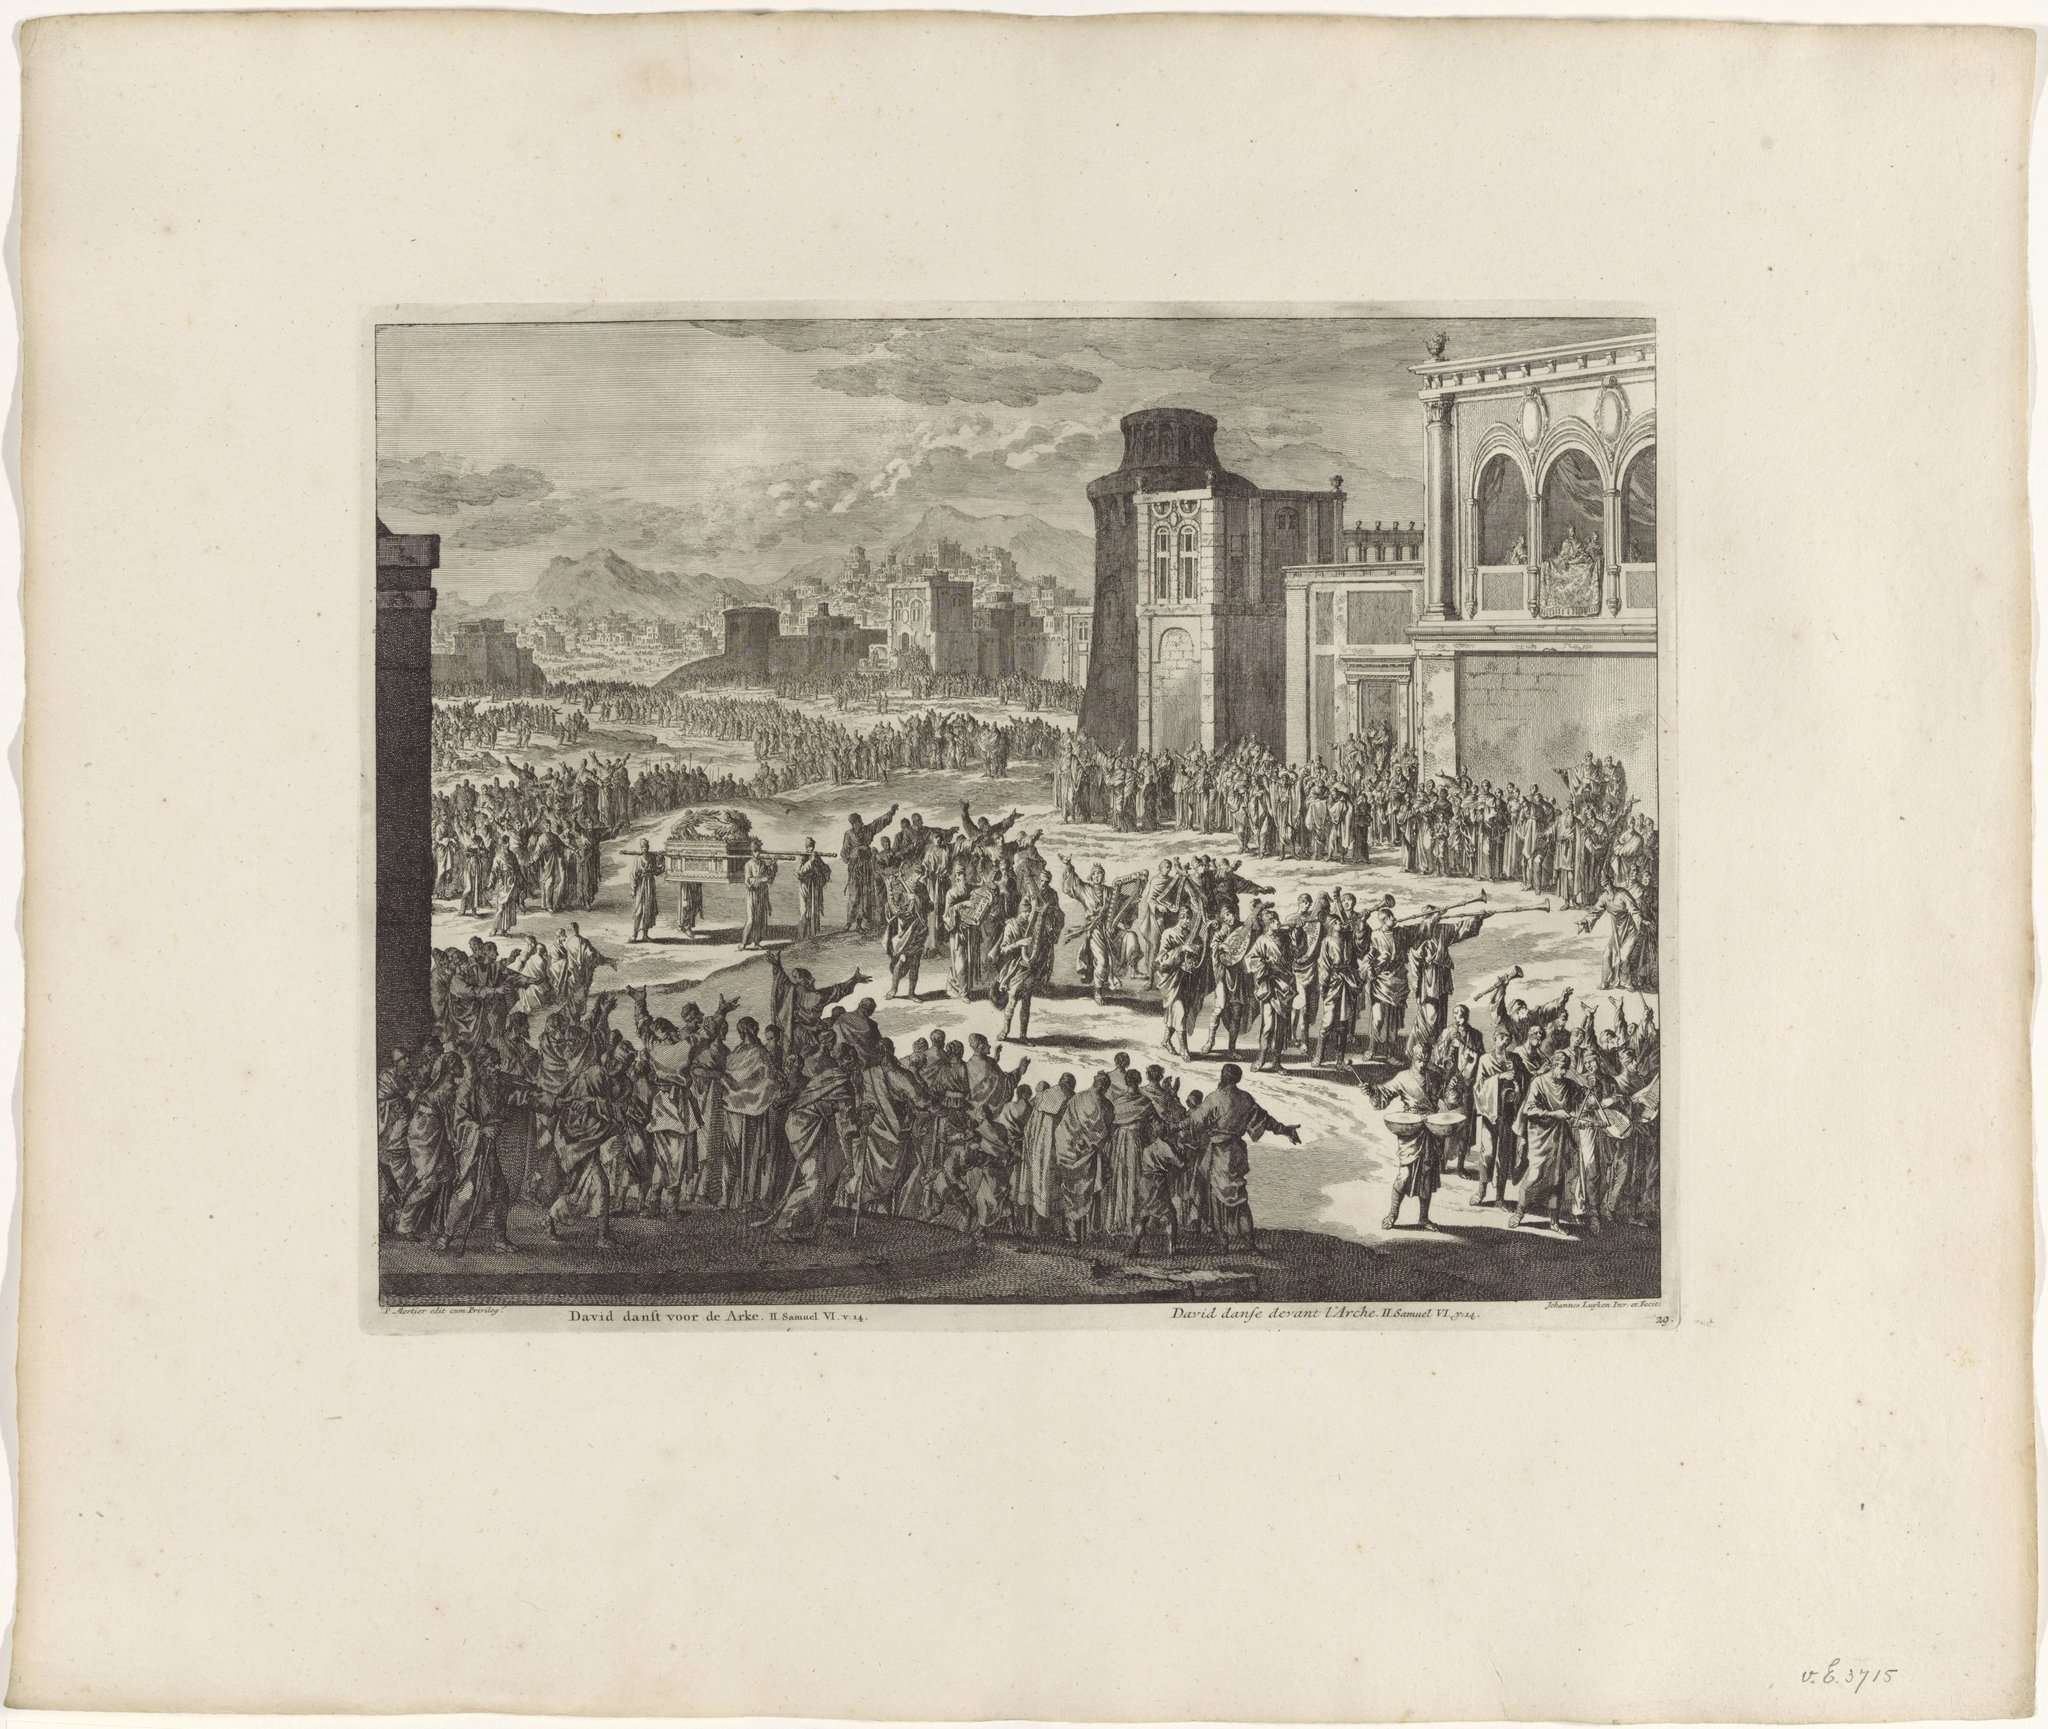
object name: book illustration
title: David danst voor de Ark des Verbonds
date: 1708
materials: paper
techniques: etching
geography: amsterdam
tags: the ark is placed on a cart driven by the sons of abinadab; david and the people dance and make music before the ark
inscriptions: collector's mark: Lugt 2228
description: Illustratie voor: Icones Biblicae Veteris et Novi Testamenti, Amsterdam: Pieter Mortier, 1708.